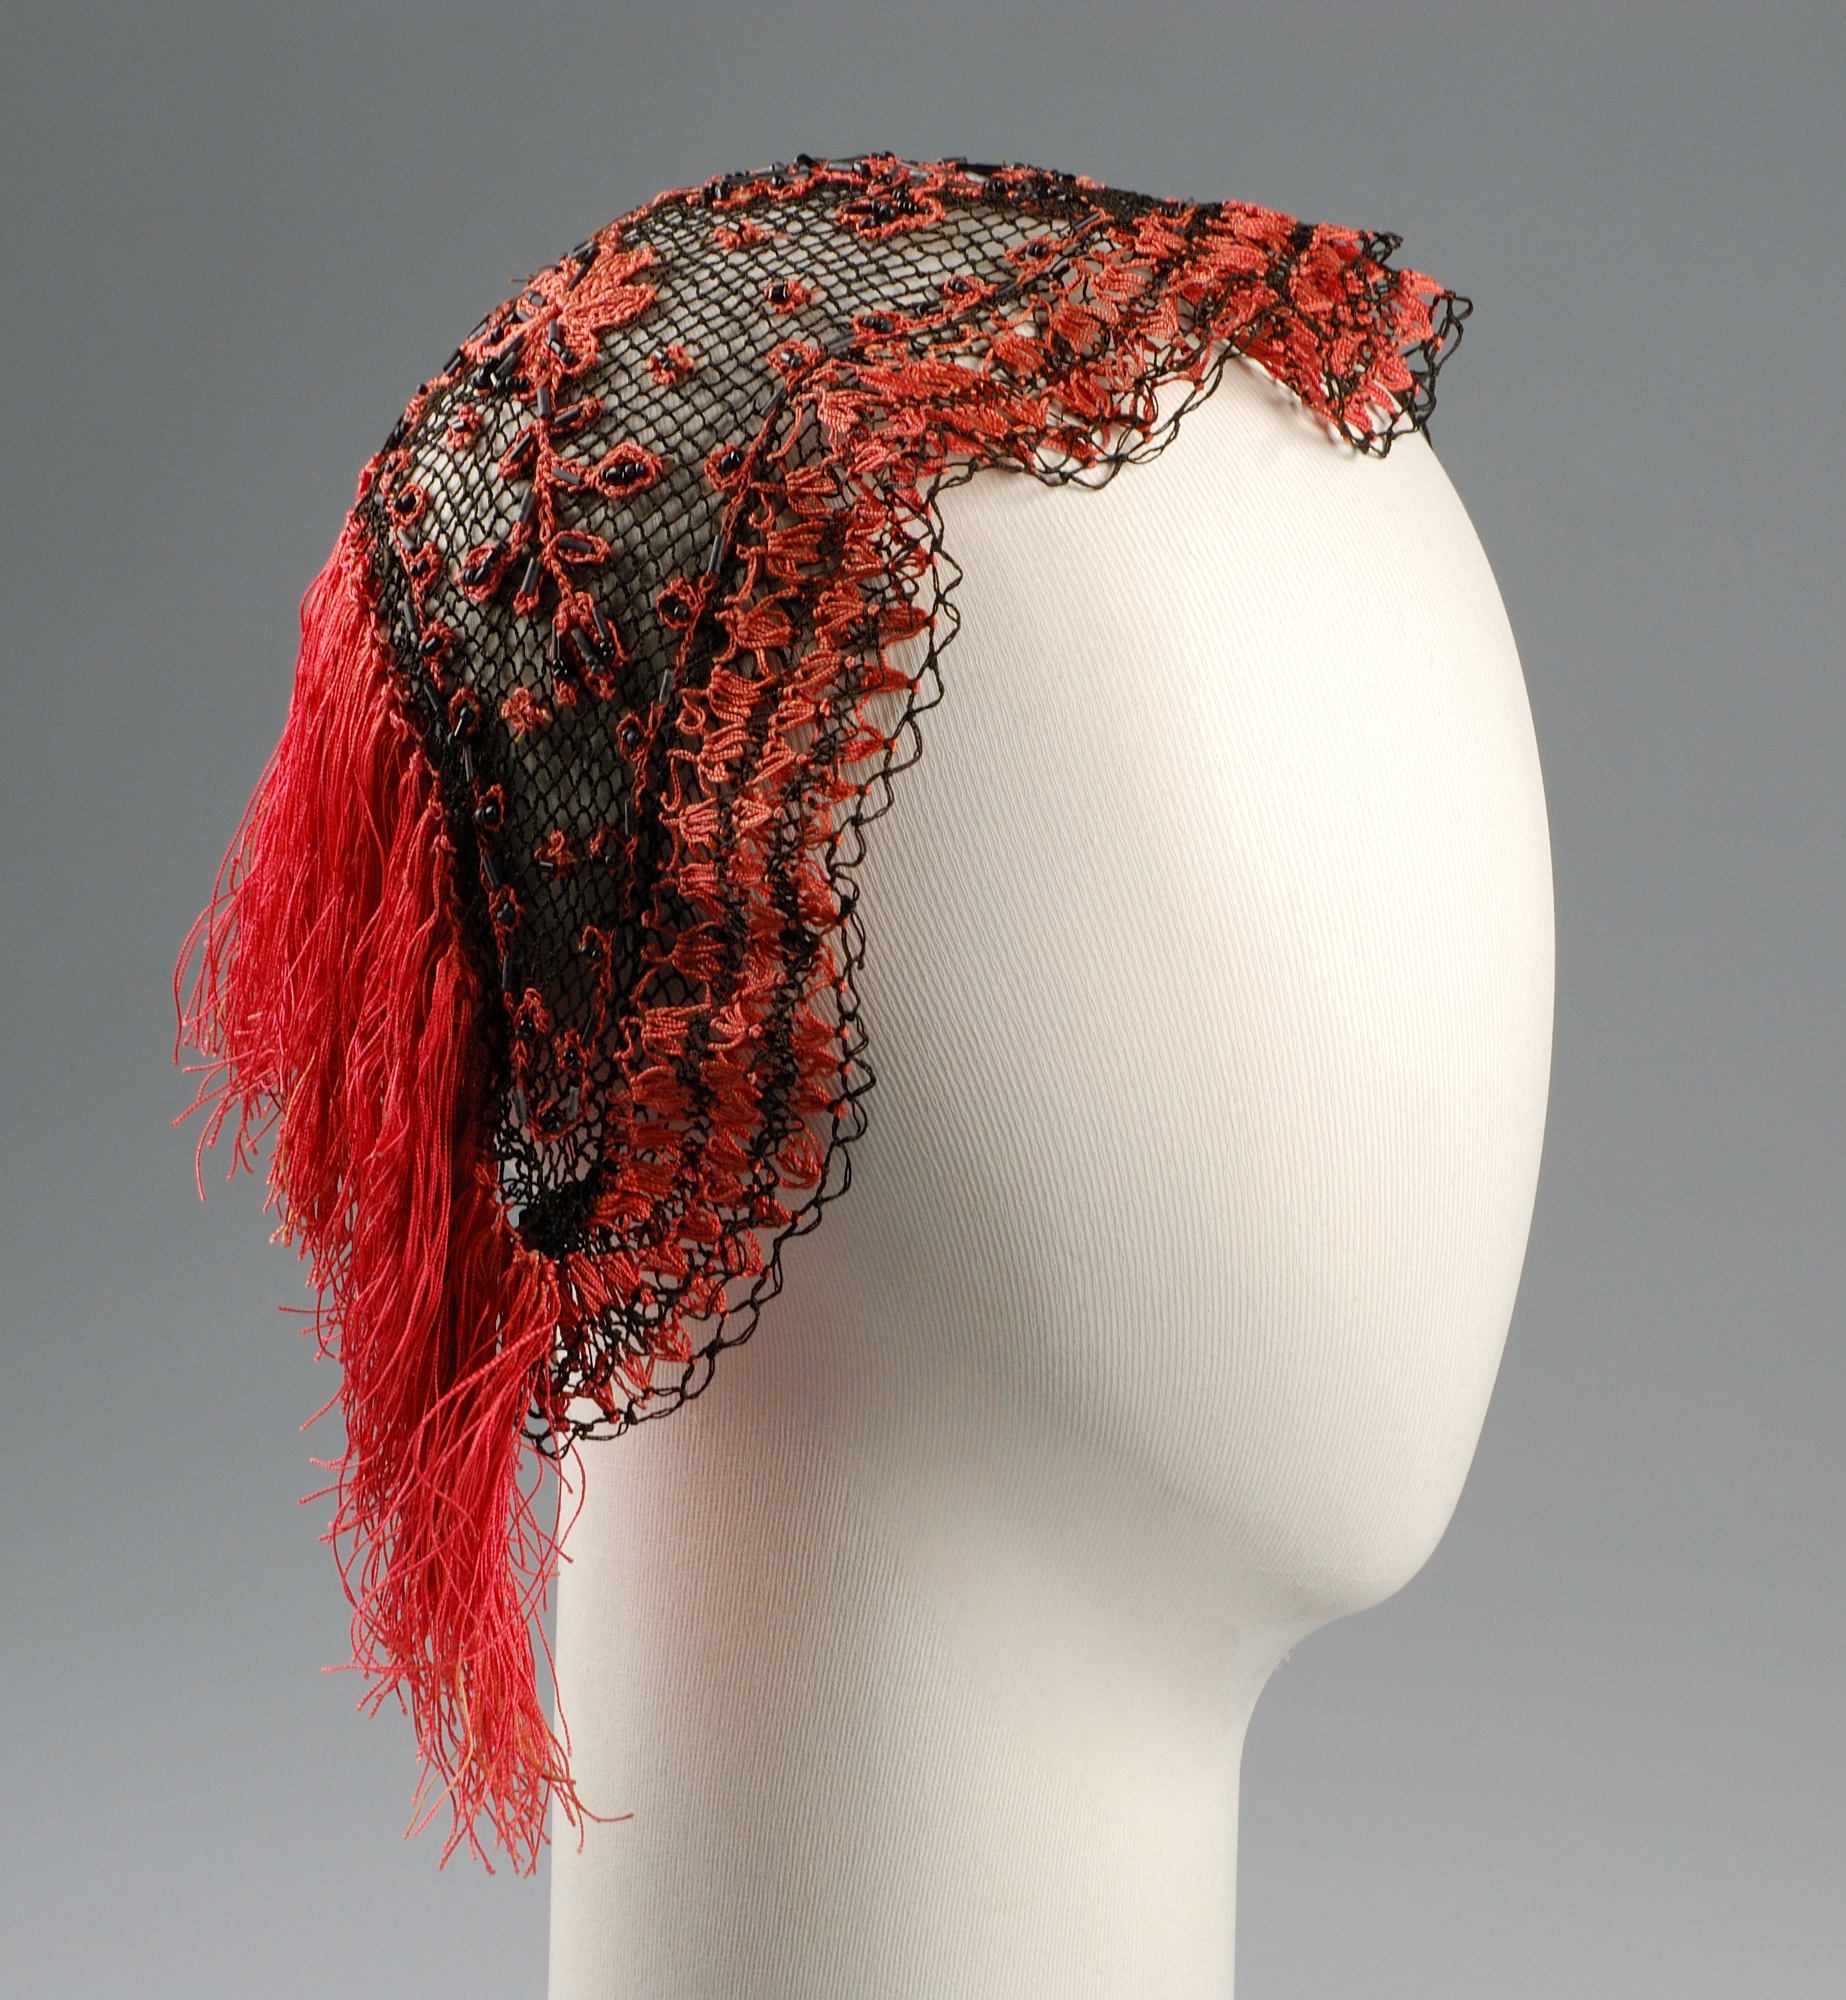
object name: evening cap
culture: american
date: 1870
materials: silk